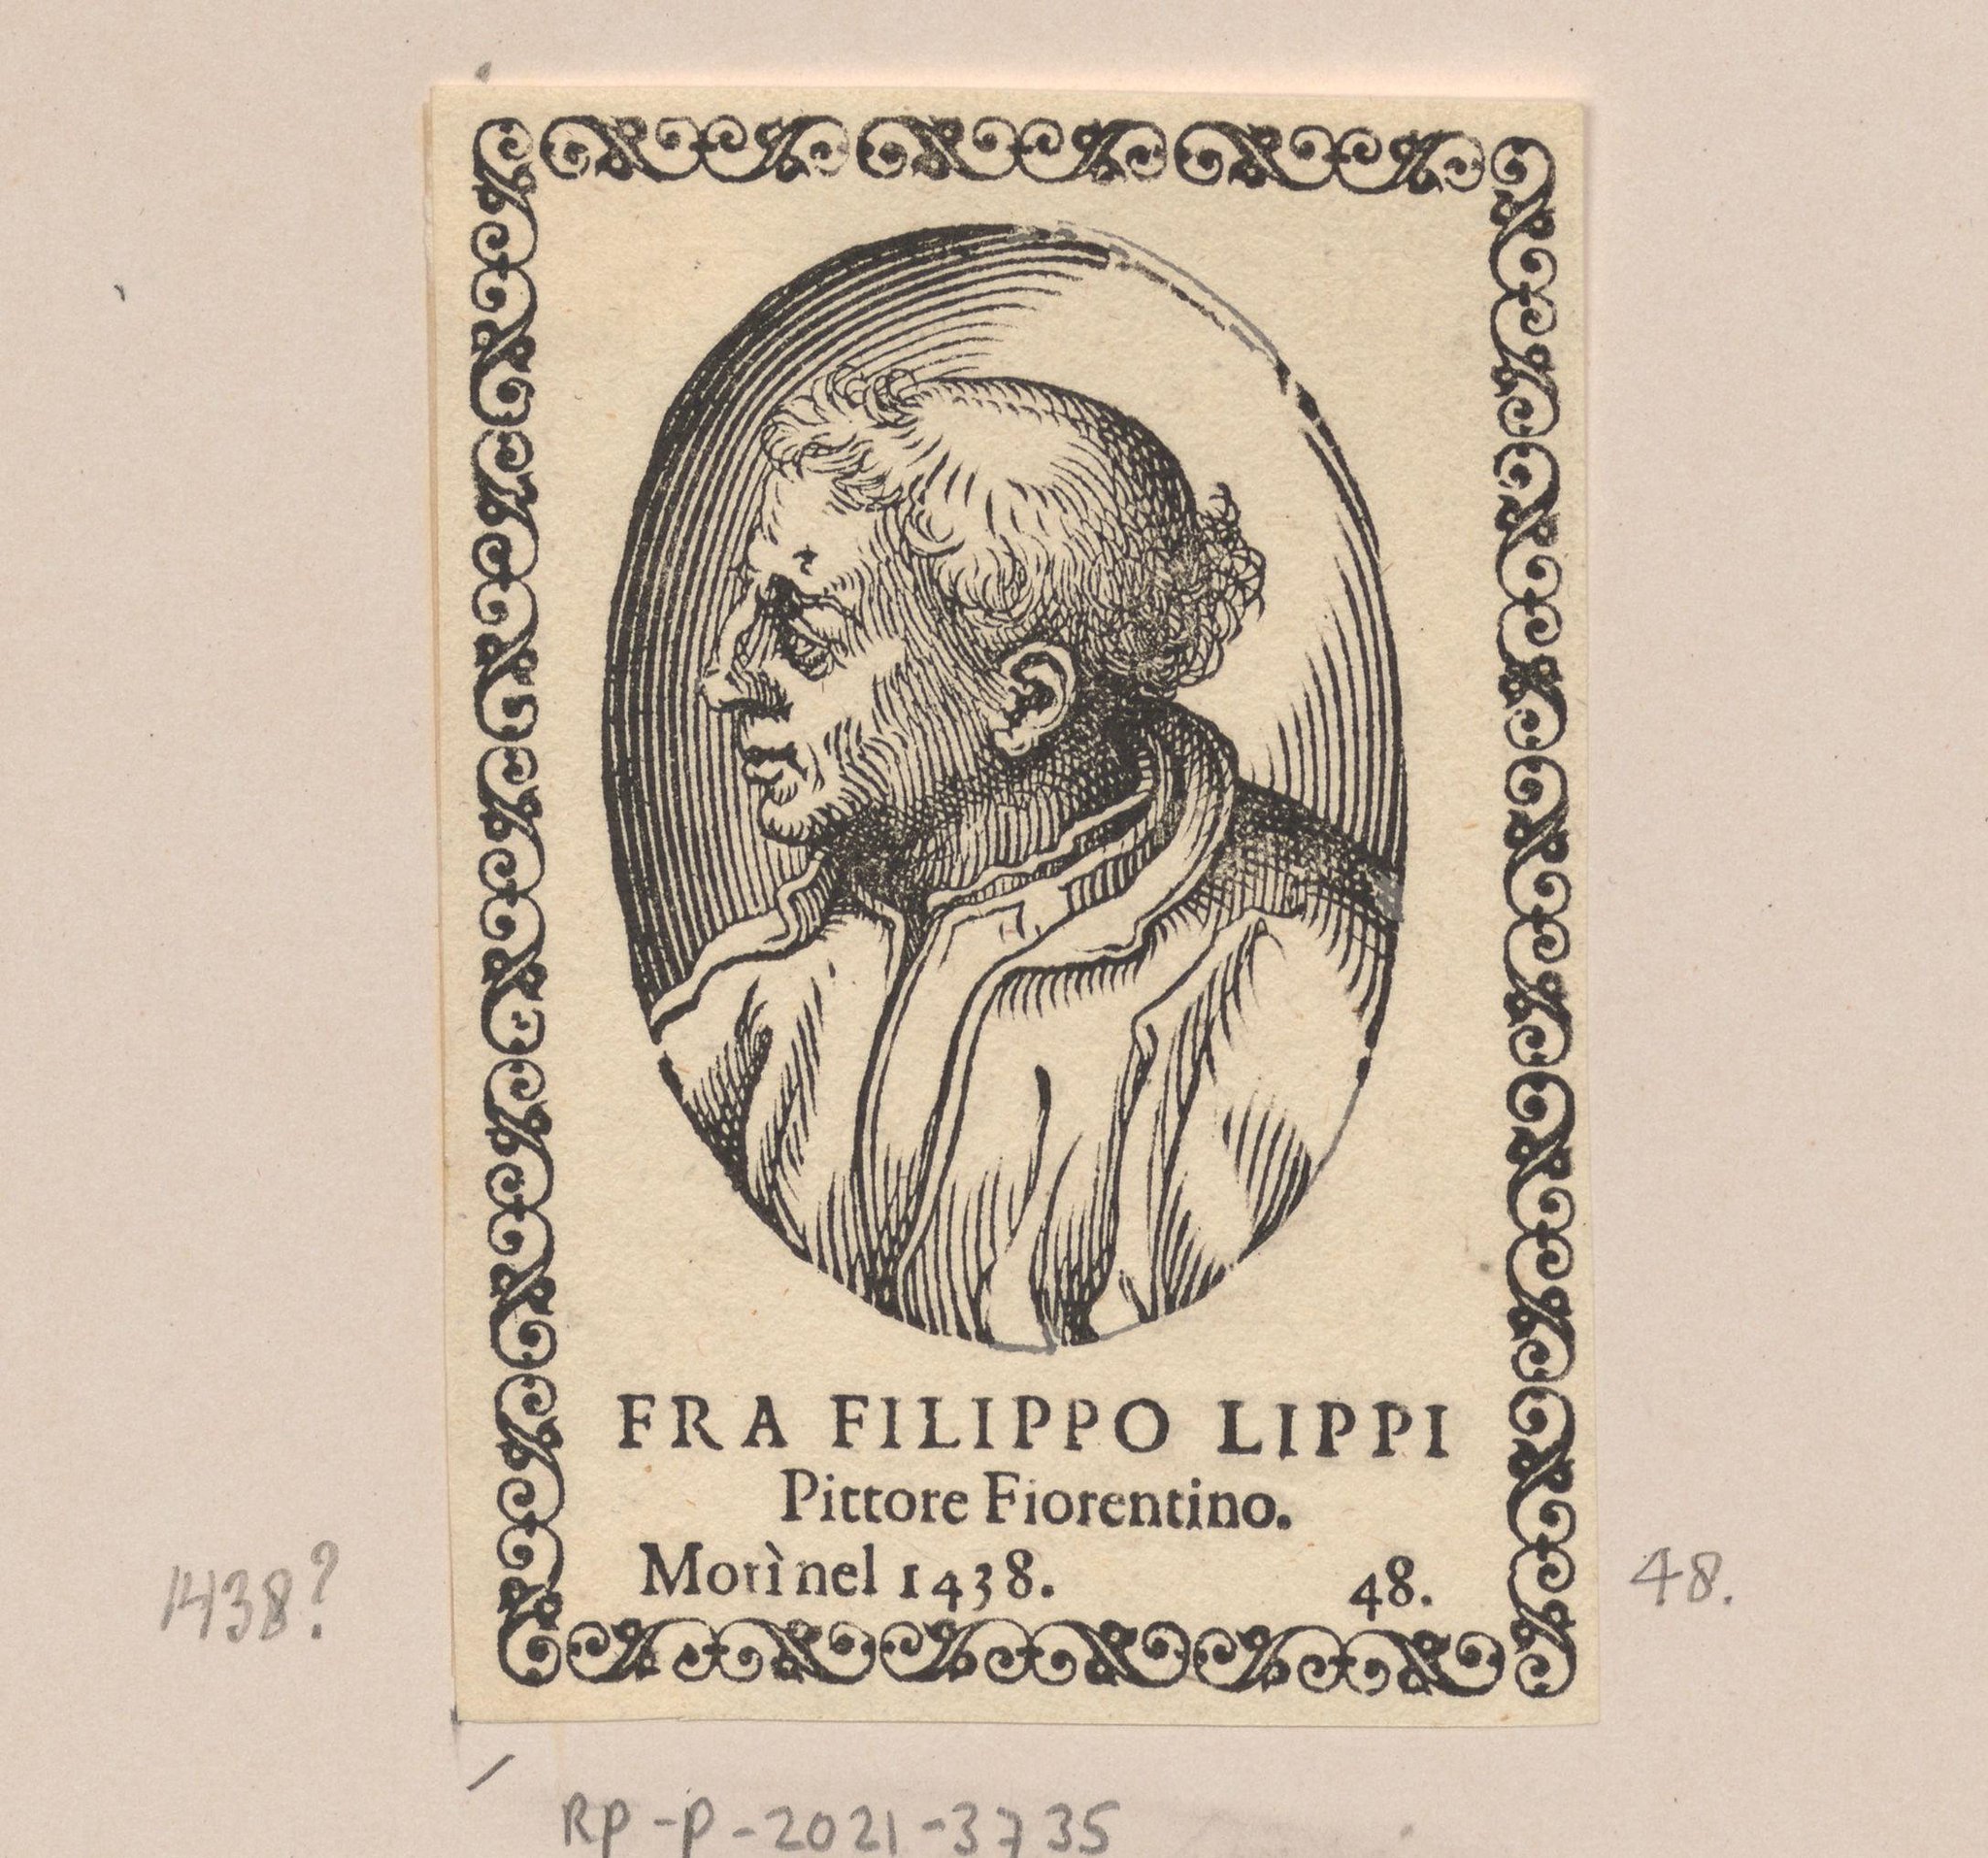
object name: print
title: Portret van Filippo Lippi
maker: cristoforo coriolano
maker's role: print maker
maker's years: 1540-1610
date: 1568-1650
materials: paper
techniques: letterpress printing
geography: italy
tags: painter, filippo lippi, historical persons, portrait, self-portrait of painter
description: Prent komt uit een editie van Vasari's 'Vite'. Prent met een andere omlijsting is gebruikt in de editie uit 1568: Vasari, Giorgio. Le vite de' piu eccellenti pittori scultori, e architettori. Florence: Filippo Giunta, 1568. En mogelijk in de editie uit 1647.